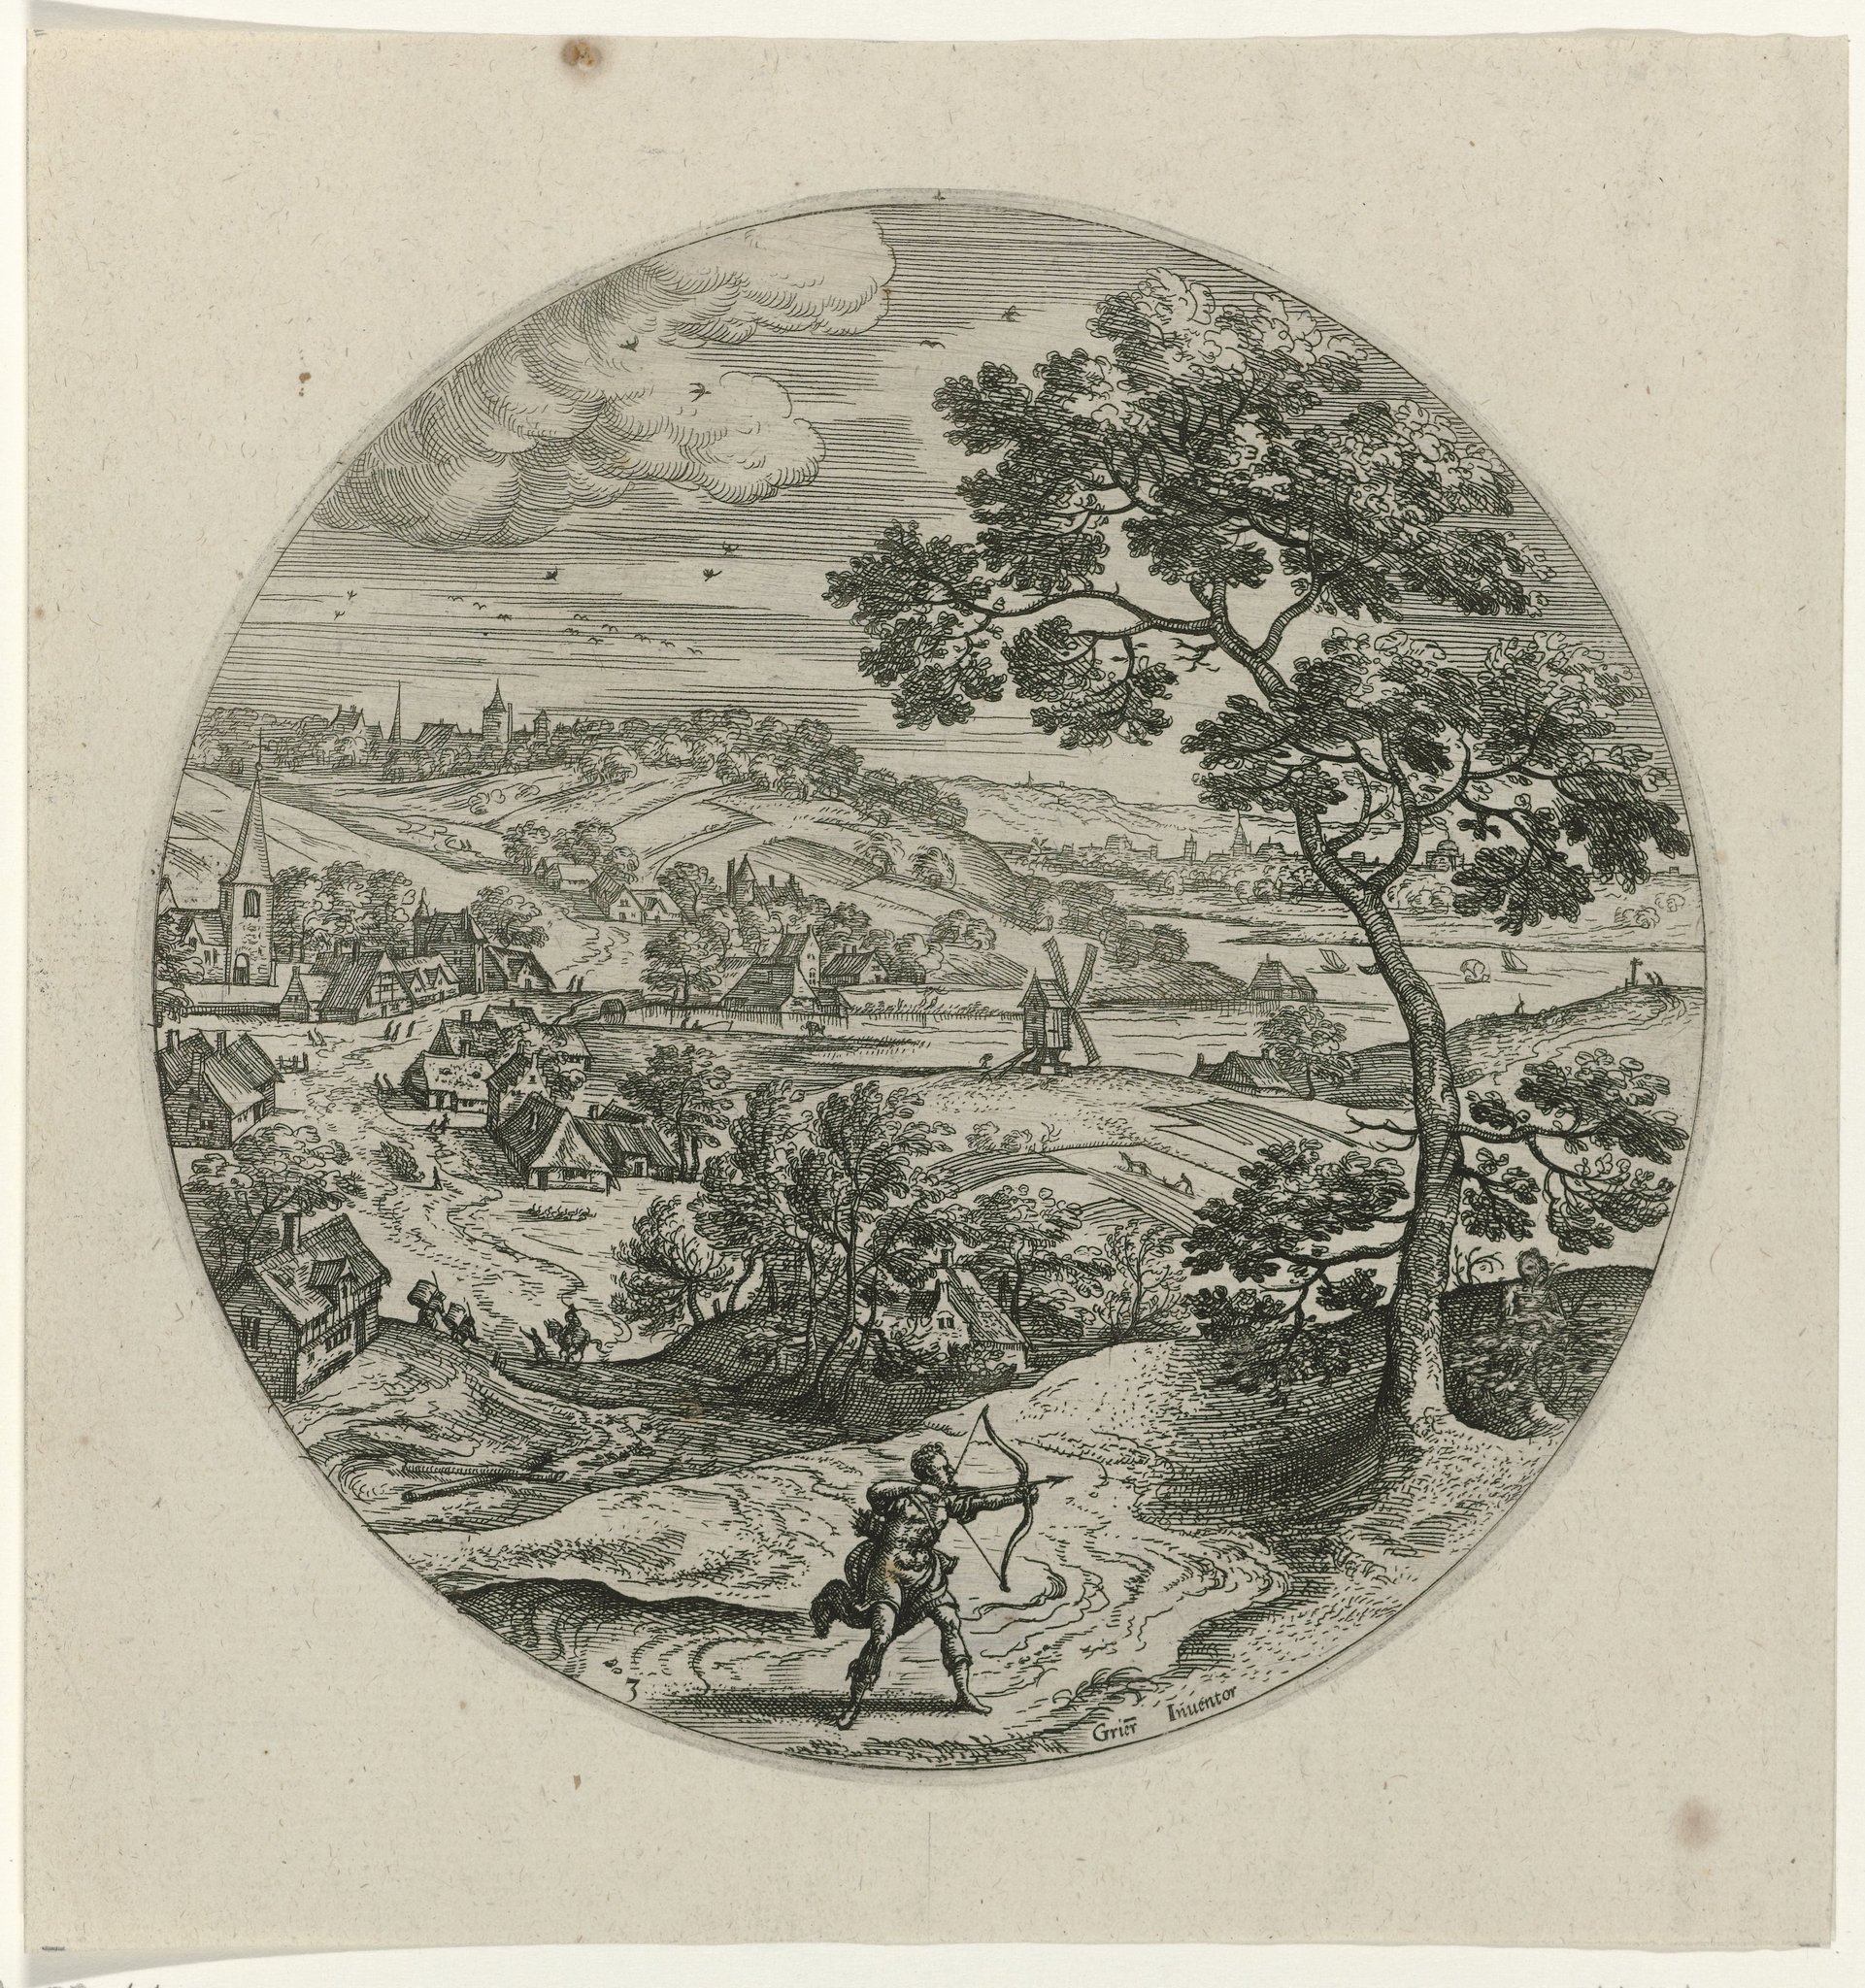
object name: print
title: Cephalus en Procris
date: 1547-1612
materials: paper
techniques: engraving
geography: antwerp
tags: procris, hidden in a thicket, hears cephalus calling on aura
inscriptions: collector's mark: Lugt 2228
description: Cephalus is op jacht. Procris heeft zich verscholen achter een struik. Nietsvermoedend spant Cephalus zijn boog . De prent is deel van een serie over het mythologische verhaal van Procris en Cephalus.